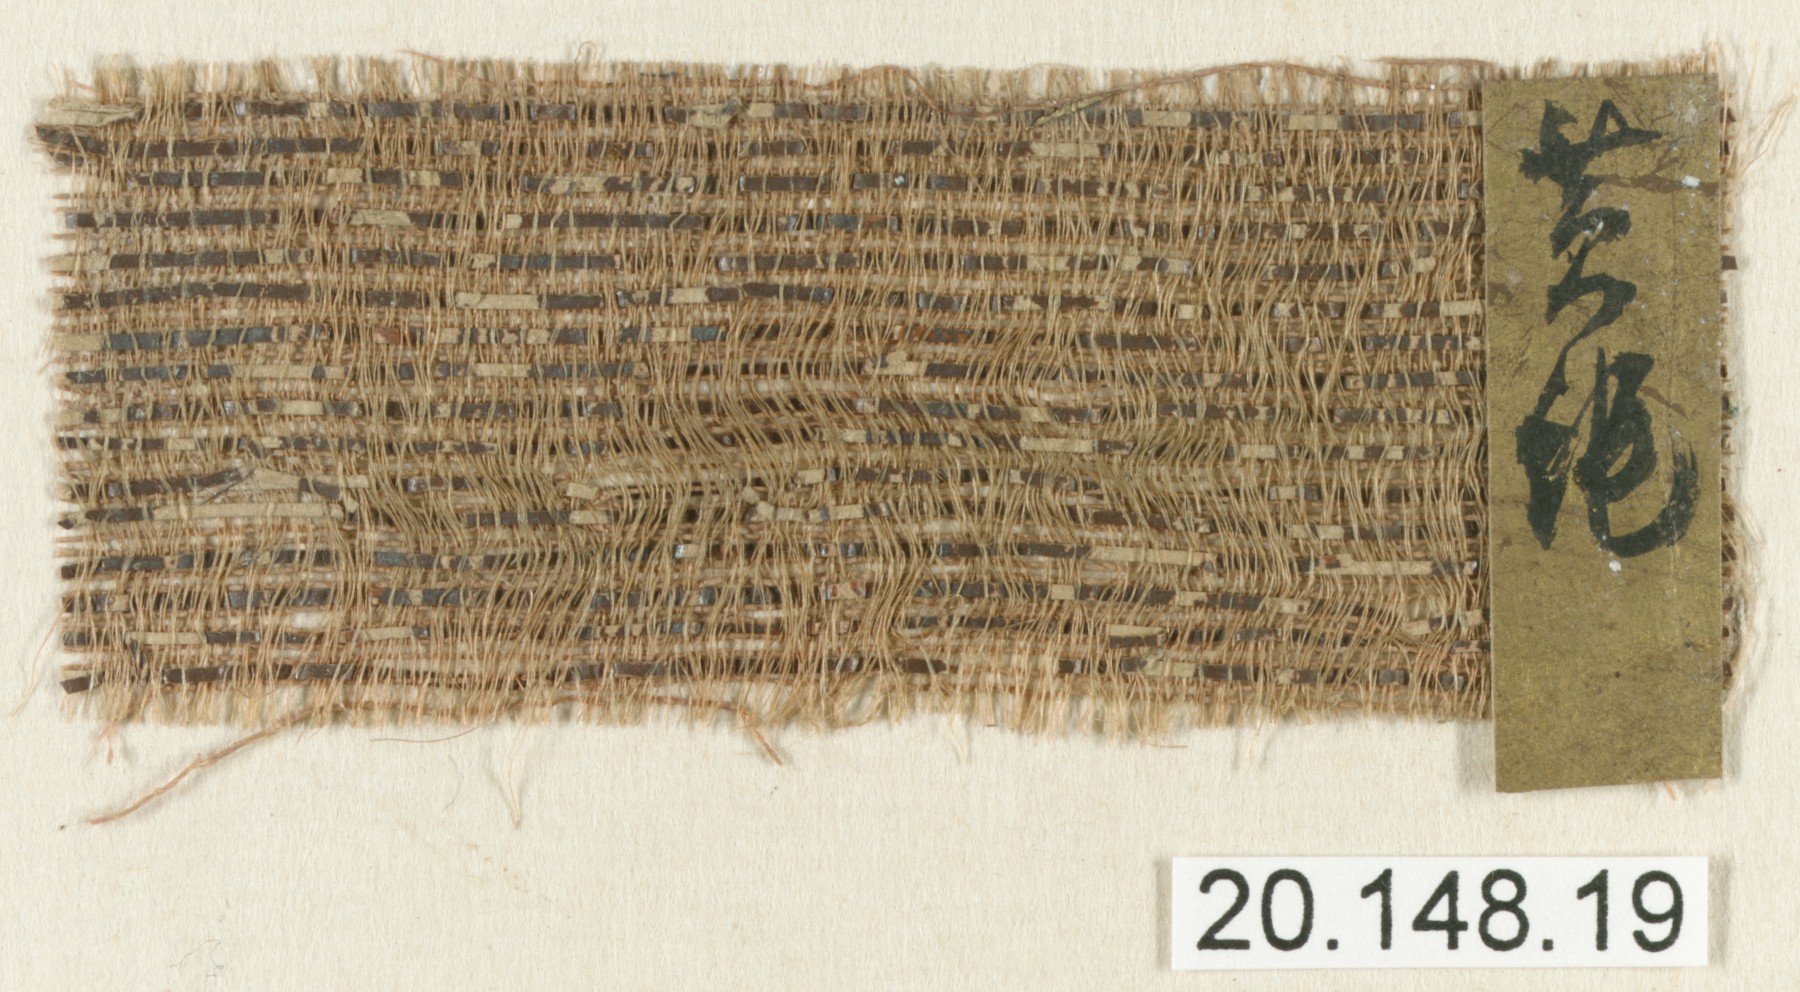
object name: piece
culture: japanese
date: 1101-1200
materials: silk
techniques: compound weave